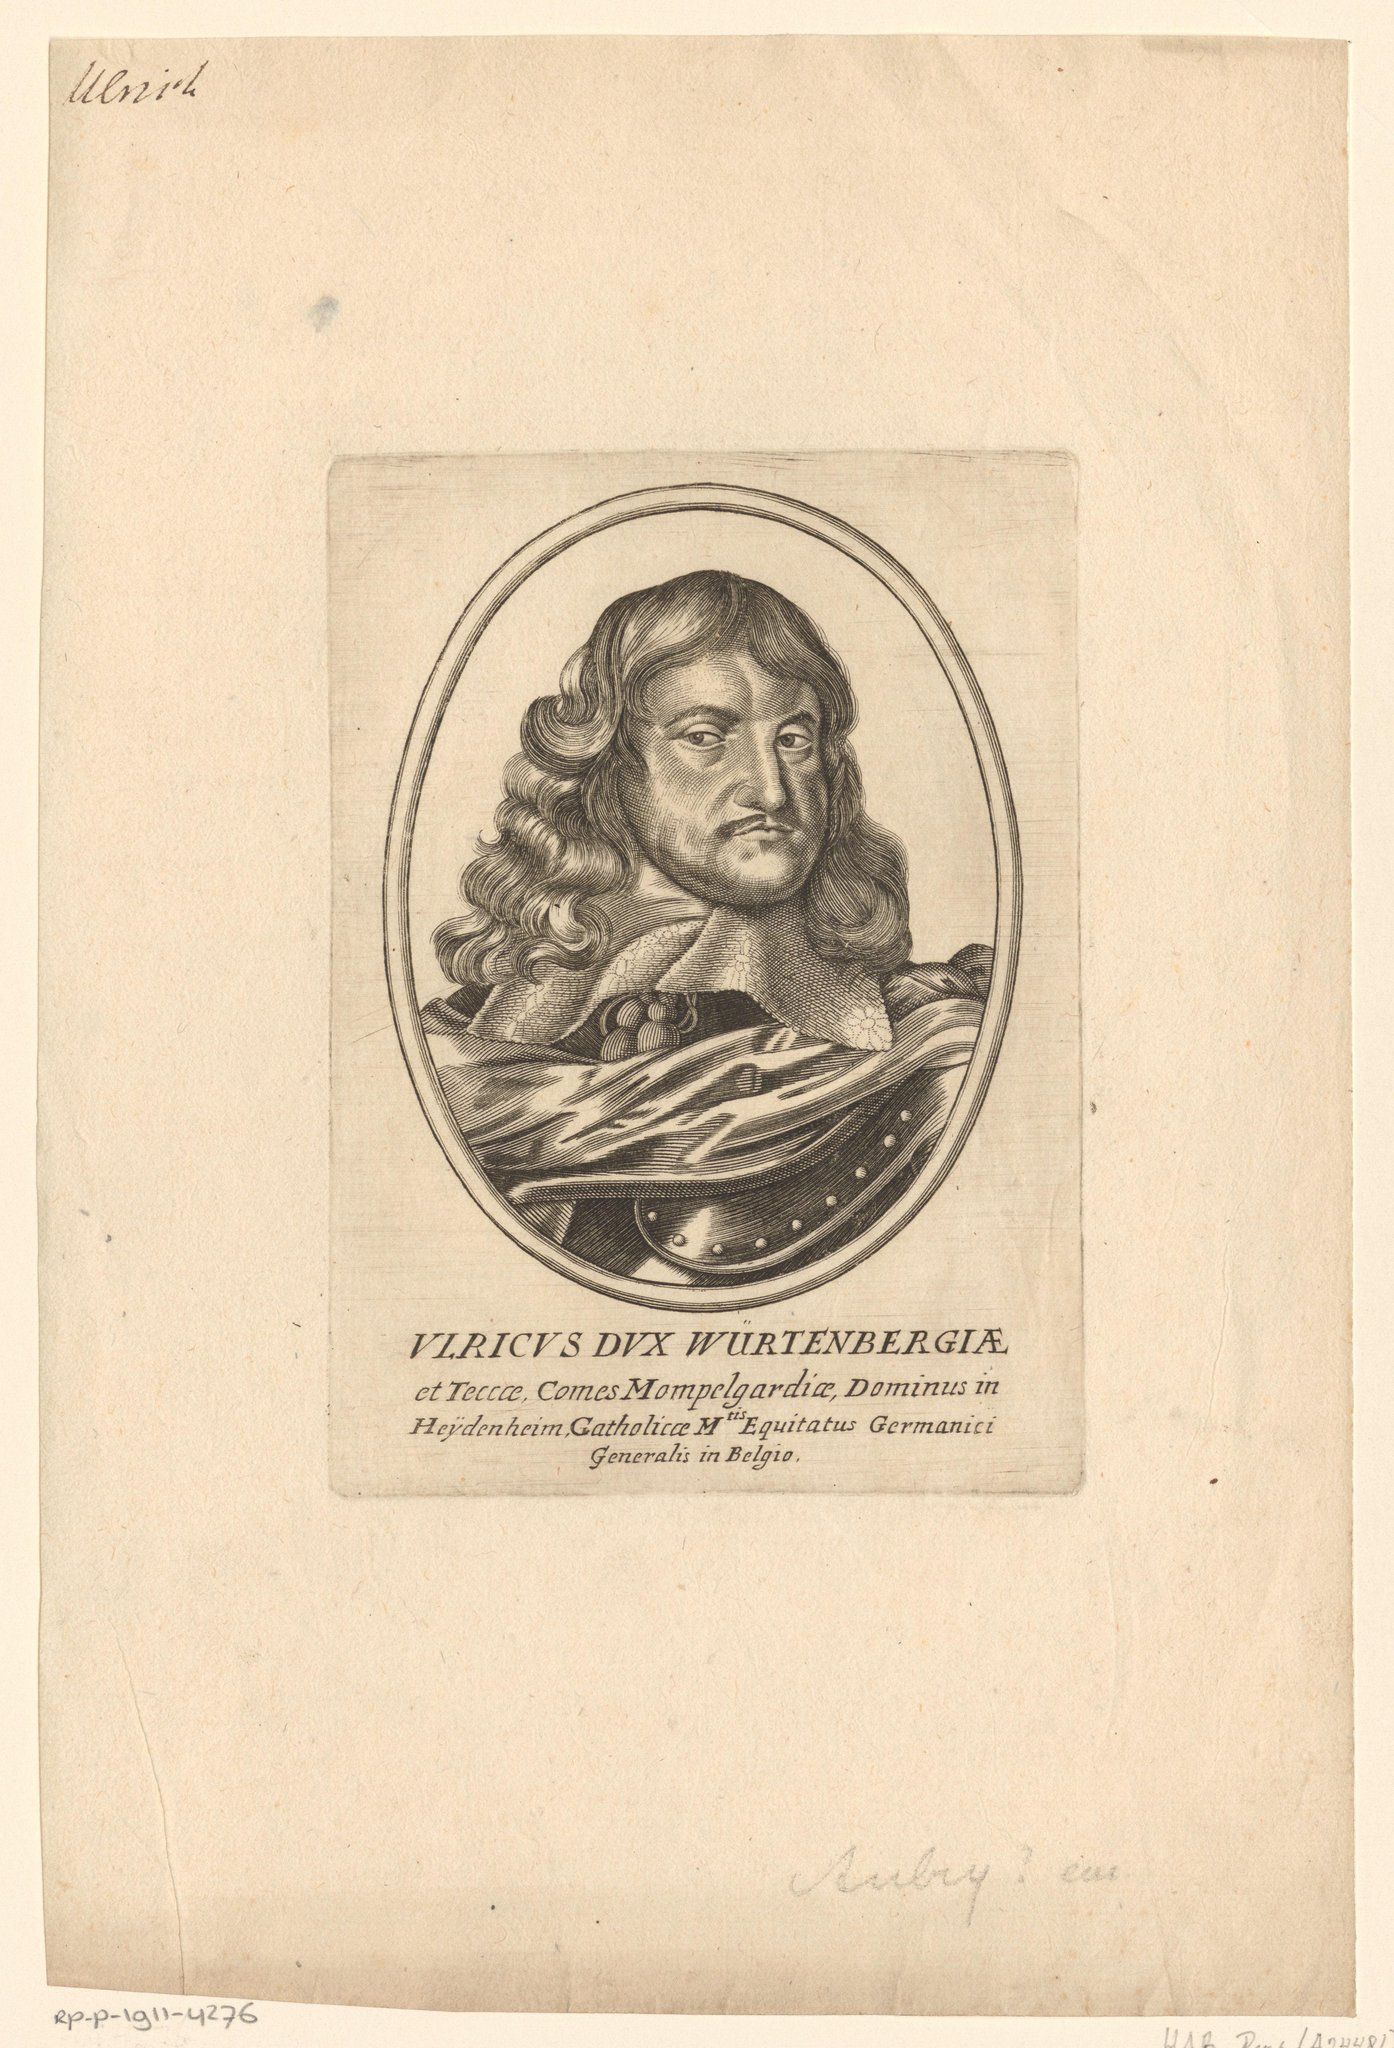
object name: print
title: Portret van Ulrich von Württemberg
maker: peter aubry (ii)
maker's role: print maker, publisher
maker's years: 1596-1668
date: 1640-1666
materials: paper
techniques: engraving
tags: ulrich von württemberg (hertog), commander-in-chief, general, marshal, historical persons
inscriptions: collector's mark: Lugt 2228